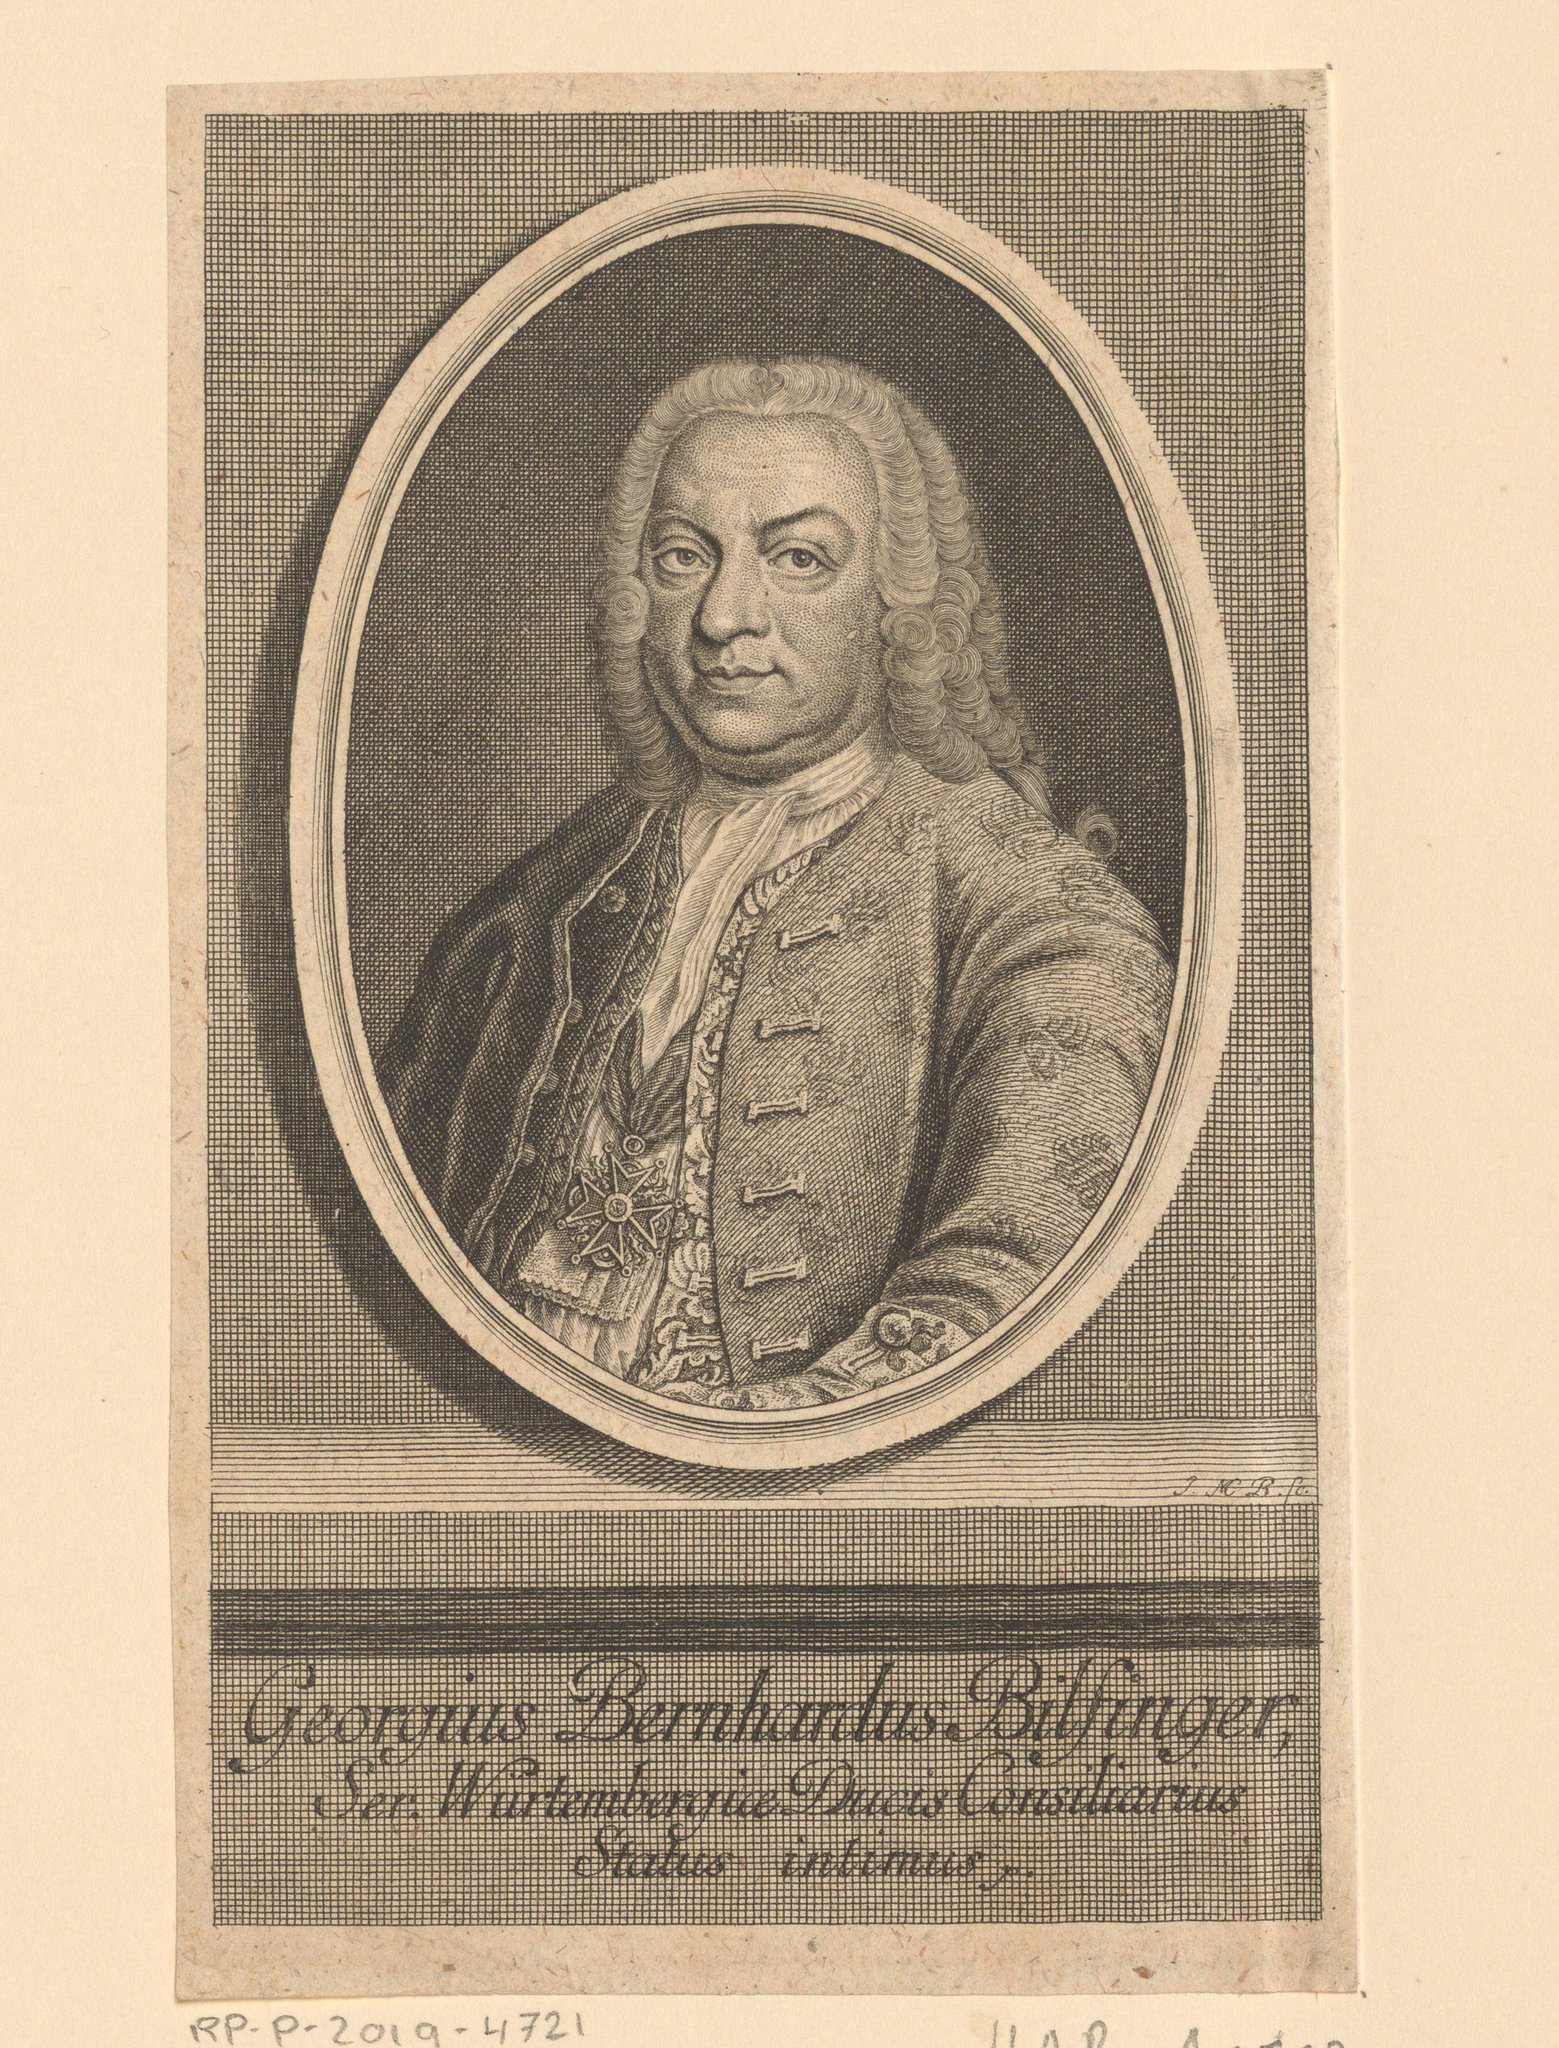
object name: print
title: Portret van Georg Bernhard Bilfinger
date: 1744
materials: paper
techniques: engraving, etching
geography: leipzig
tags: historical persons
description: Prent uit: Zuverläßige Nachrichten von dem gegenwärtigen Zustande, Veränderung und Wachsthum der Wissenschaften. Leipzig: Johann Friedrich Gleditsch, 1744, dl. 56.